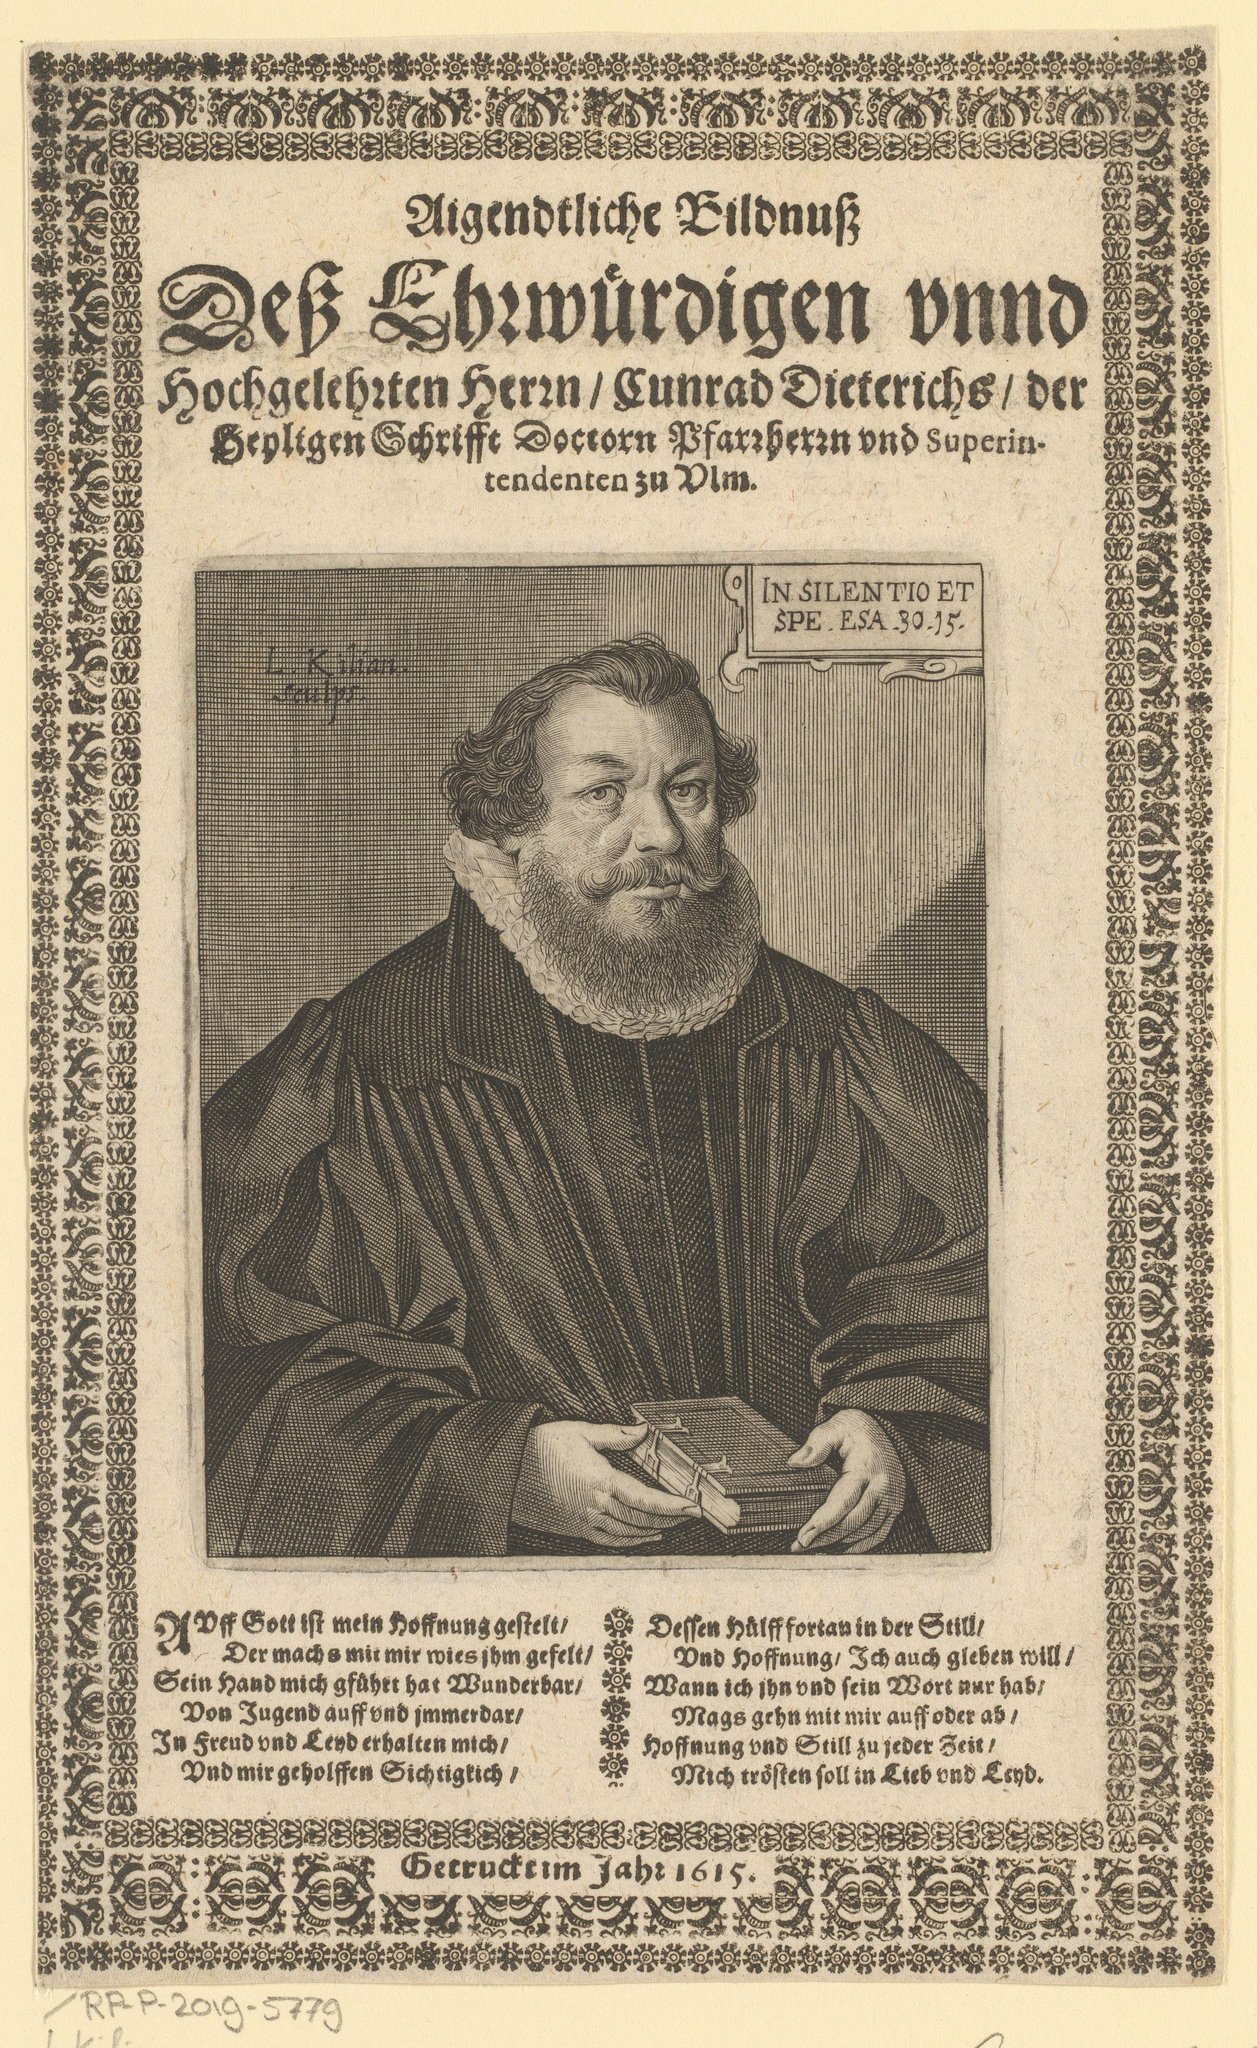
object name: print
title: Portretten van eerbiedwaardige en geleerde mannen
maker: lucas kilian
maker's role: draughtsman, print maker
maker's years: 1579-1637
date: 1615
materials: paper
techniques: engraving, letterpress printing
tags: historical persons, book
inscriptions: collector's mark: Lugt 2228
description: Onder het portret een twaalfregelig vers.